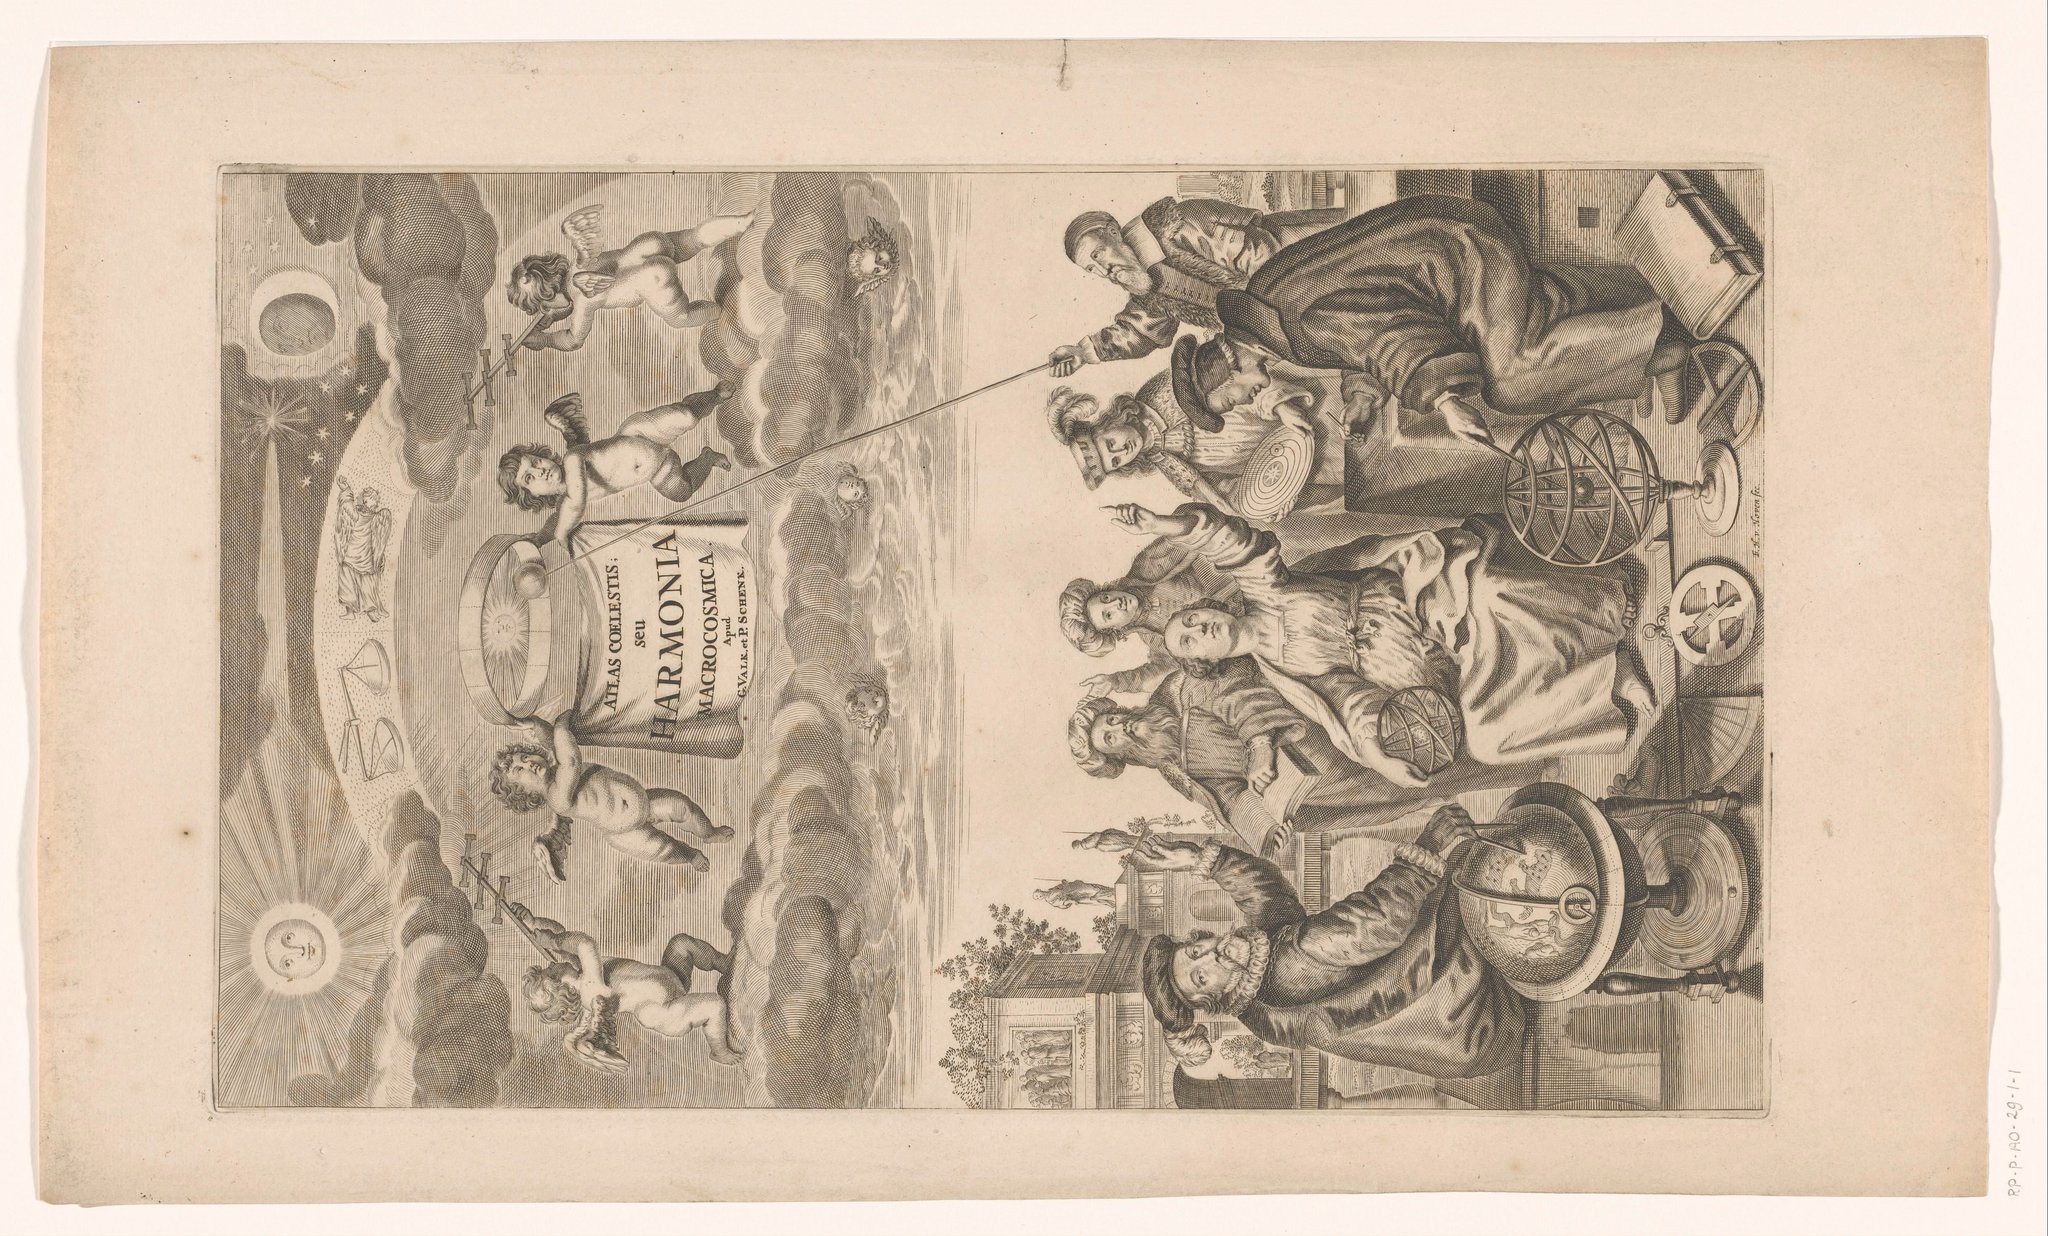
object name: print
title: Atlas Coelestis seu Harmonia Macrocosmica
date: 1660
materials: paper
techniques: engraving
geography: amsterdam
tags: prague, tycho brahe, 'astronomia', 'cosmografia'; 'cosmografia' (ripa), group of scholars or philosophers, astronomical instruments, urania (one of the muses); 'urania' (ripa), star-globe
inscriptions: collector's mark: Lugt 2228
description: Een groep astronomen rond Urania, de personificatie van de astronomie. Links zit de astronoom Tycho Brahe, rechts Nicolaas Copernicus. Achter Urania staan, van links naar rechts, Claudius Ptolemaeus, mogelijk Albategnius of de auteur, koning Alfons X van Castilië en Philip Lansbergen. Op de voorgrond hemelglobes en meetkundige instrumenten. In de hemel zijn de zon, de maan en de dierenriem te zien.